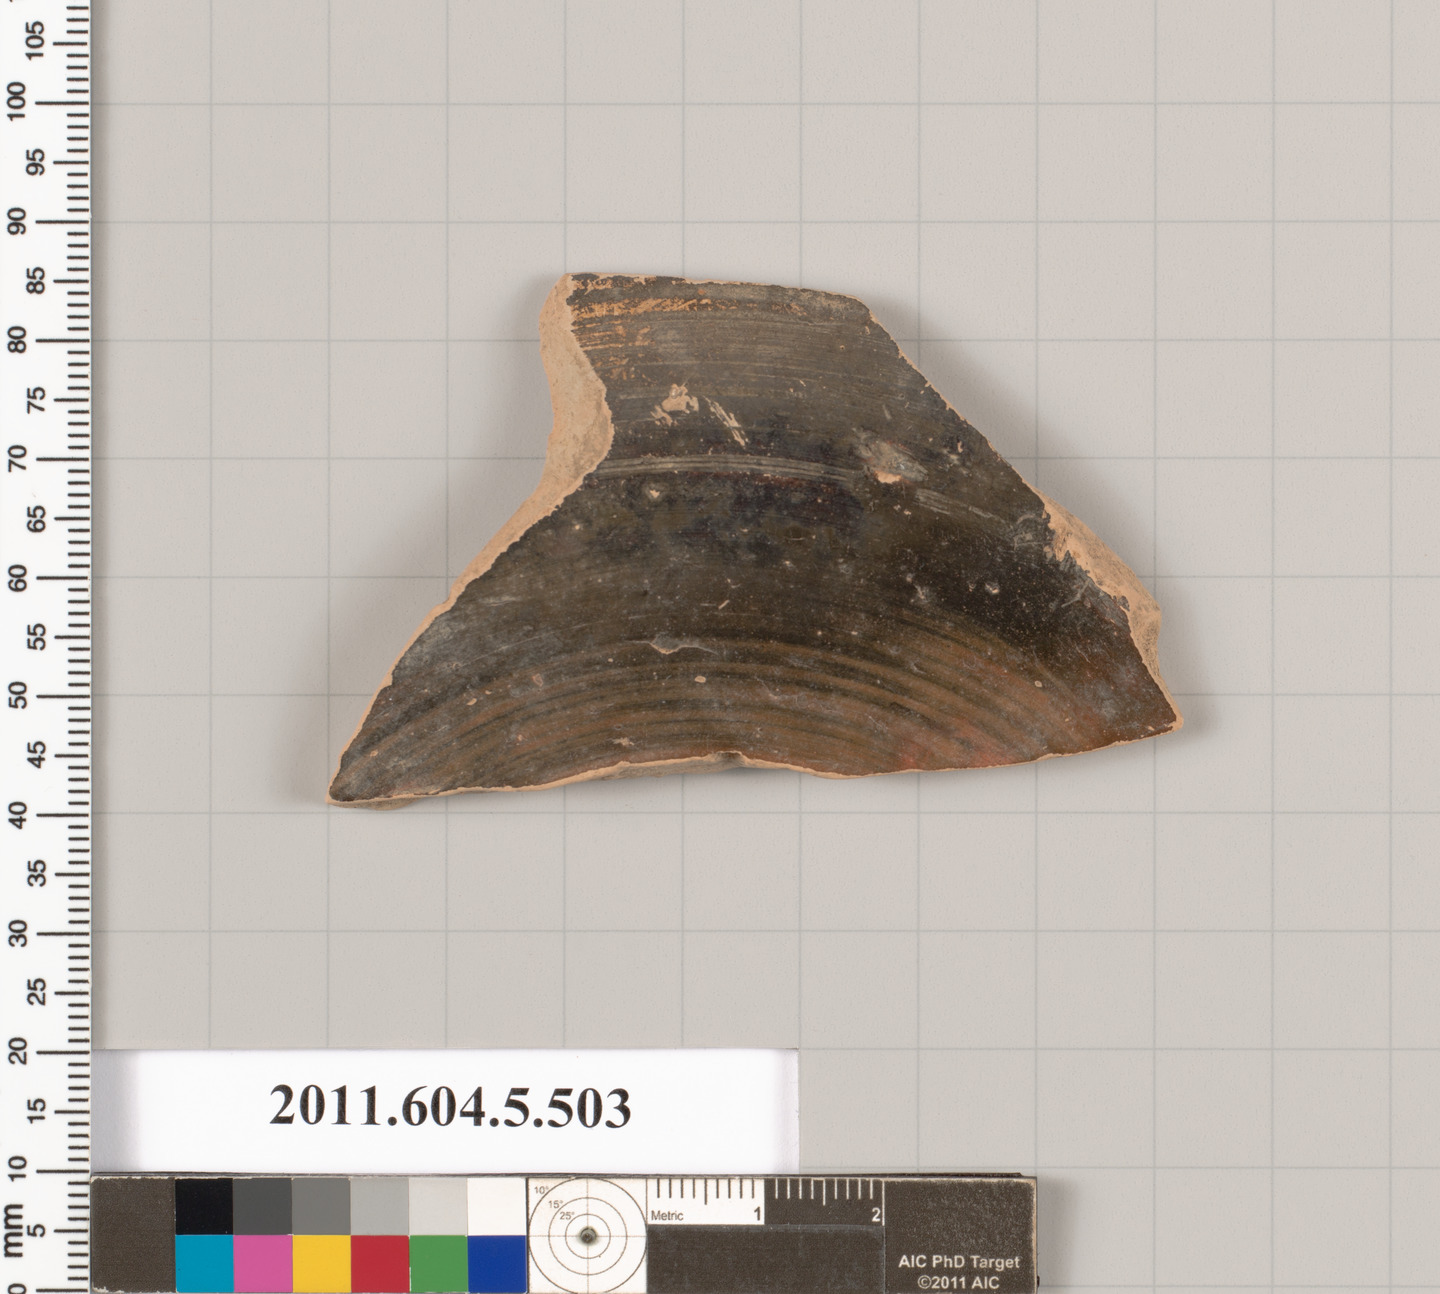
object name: kylix fragment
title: Terracotta fragment of a kylix (drinking cup)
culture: greek, attic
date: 600-401 BCE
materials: terracotta